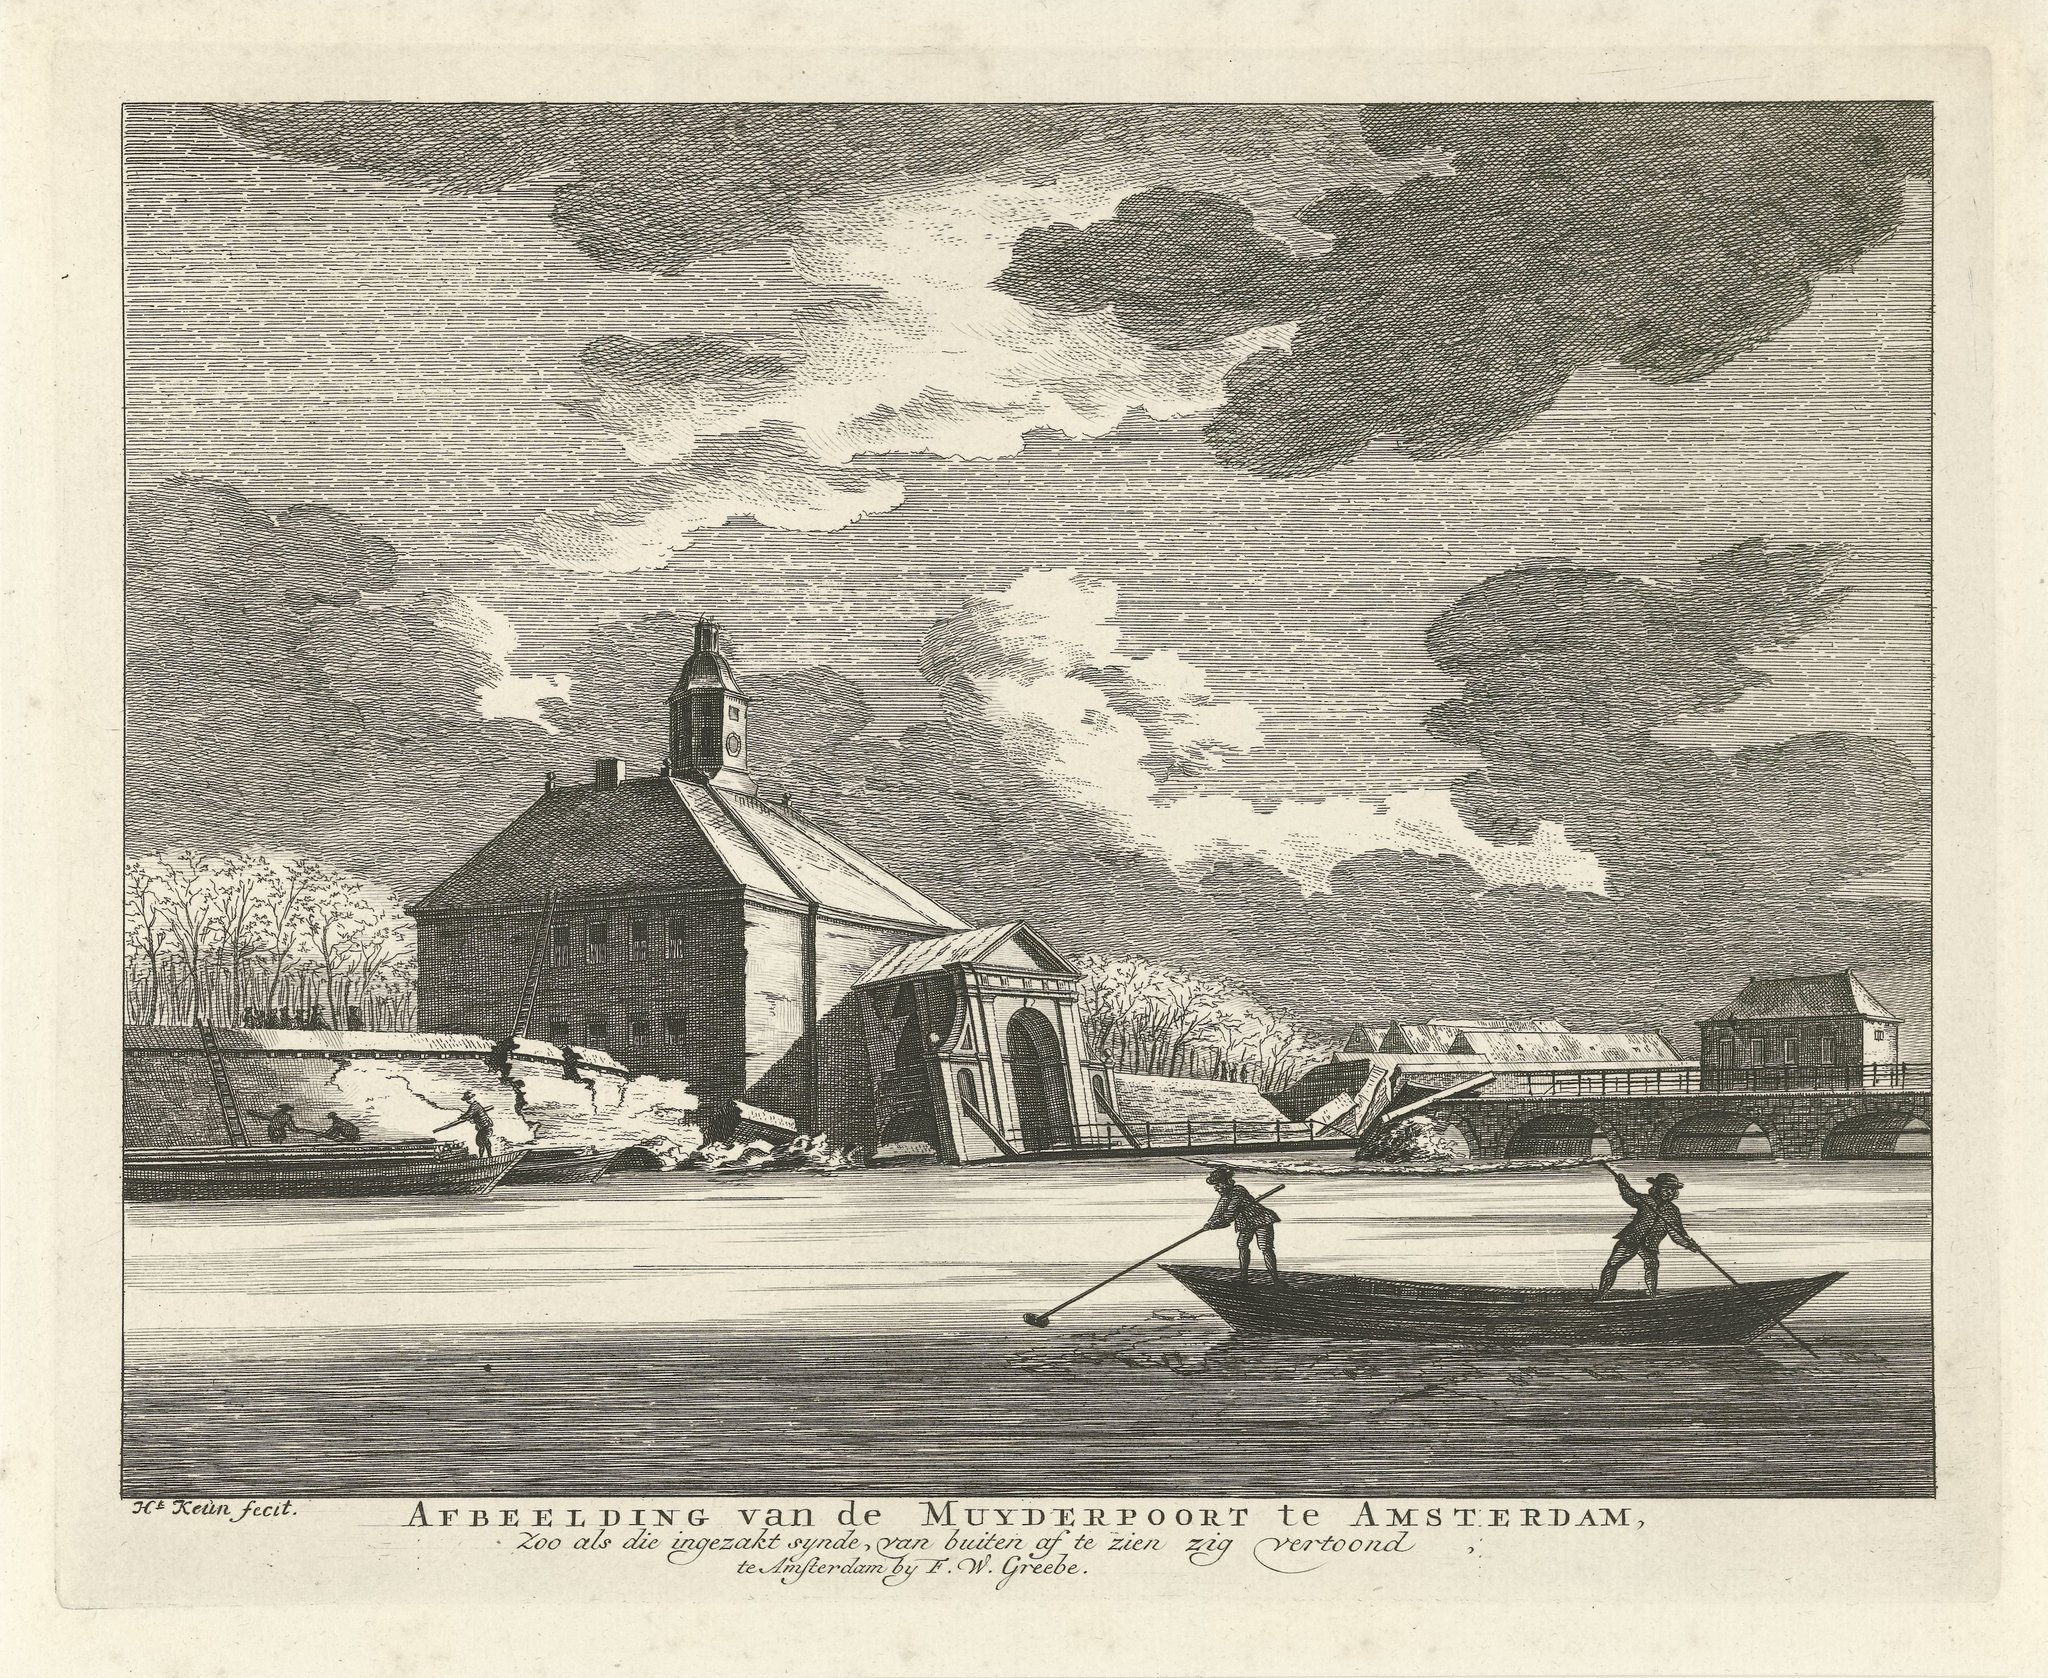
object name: print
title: Afbeelding van de Muyderpoort te Amsterdam, Zoo als die ingezakt synde, van buiten af te zien zig vertoond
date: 1769-1774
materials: paper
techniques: etching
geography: amsterdam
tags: rowing-boat, canoe, etc., city-gate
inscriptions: collector's mark: Lugt 2228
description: De verzakte Muiderpoort te Amsterdam, gezien vanaf de Singelgracht, 30 januari 1769. Op de voorgrond een schuit met twee mannen.